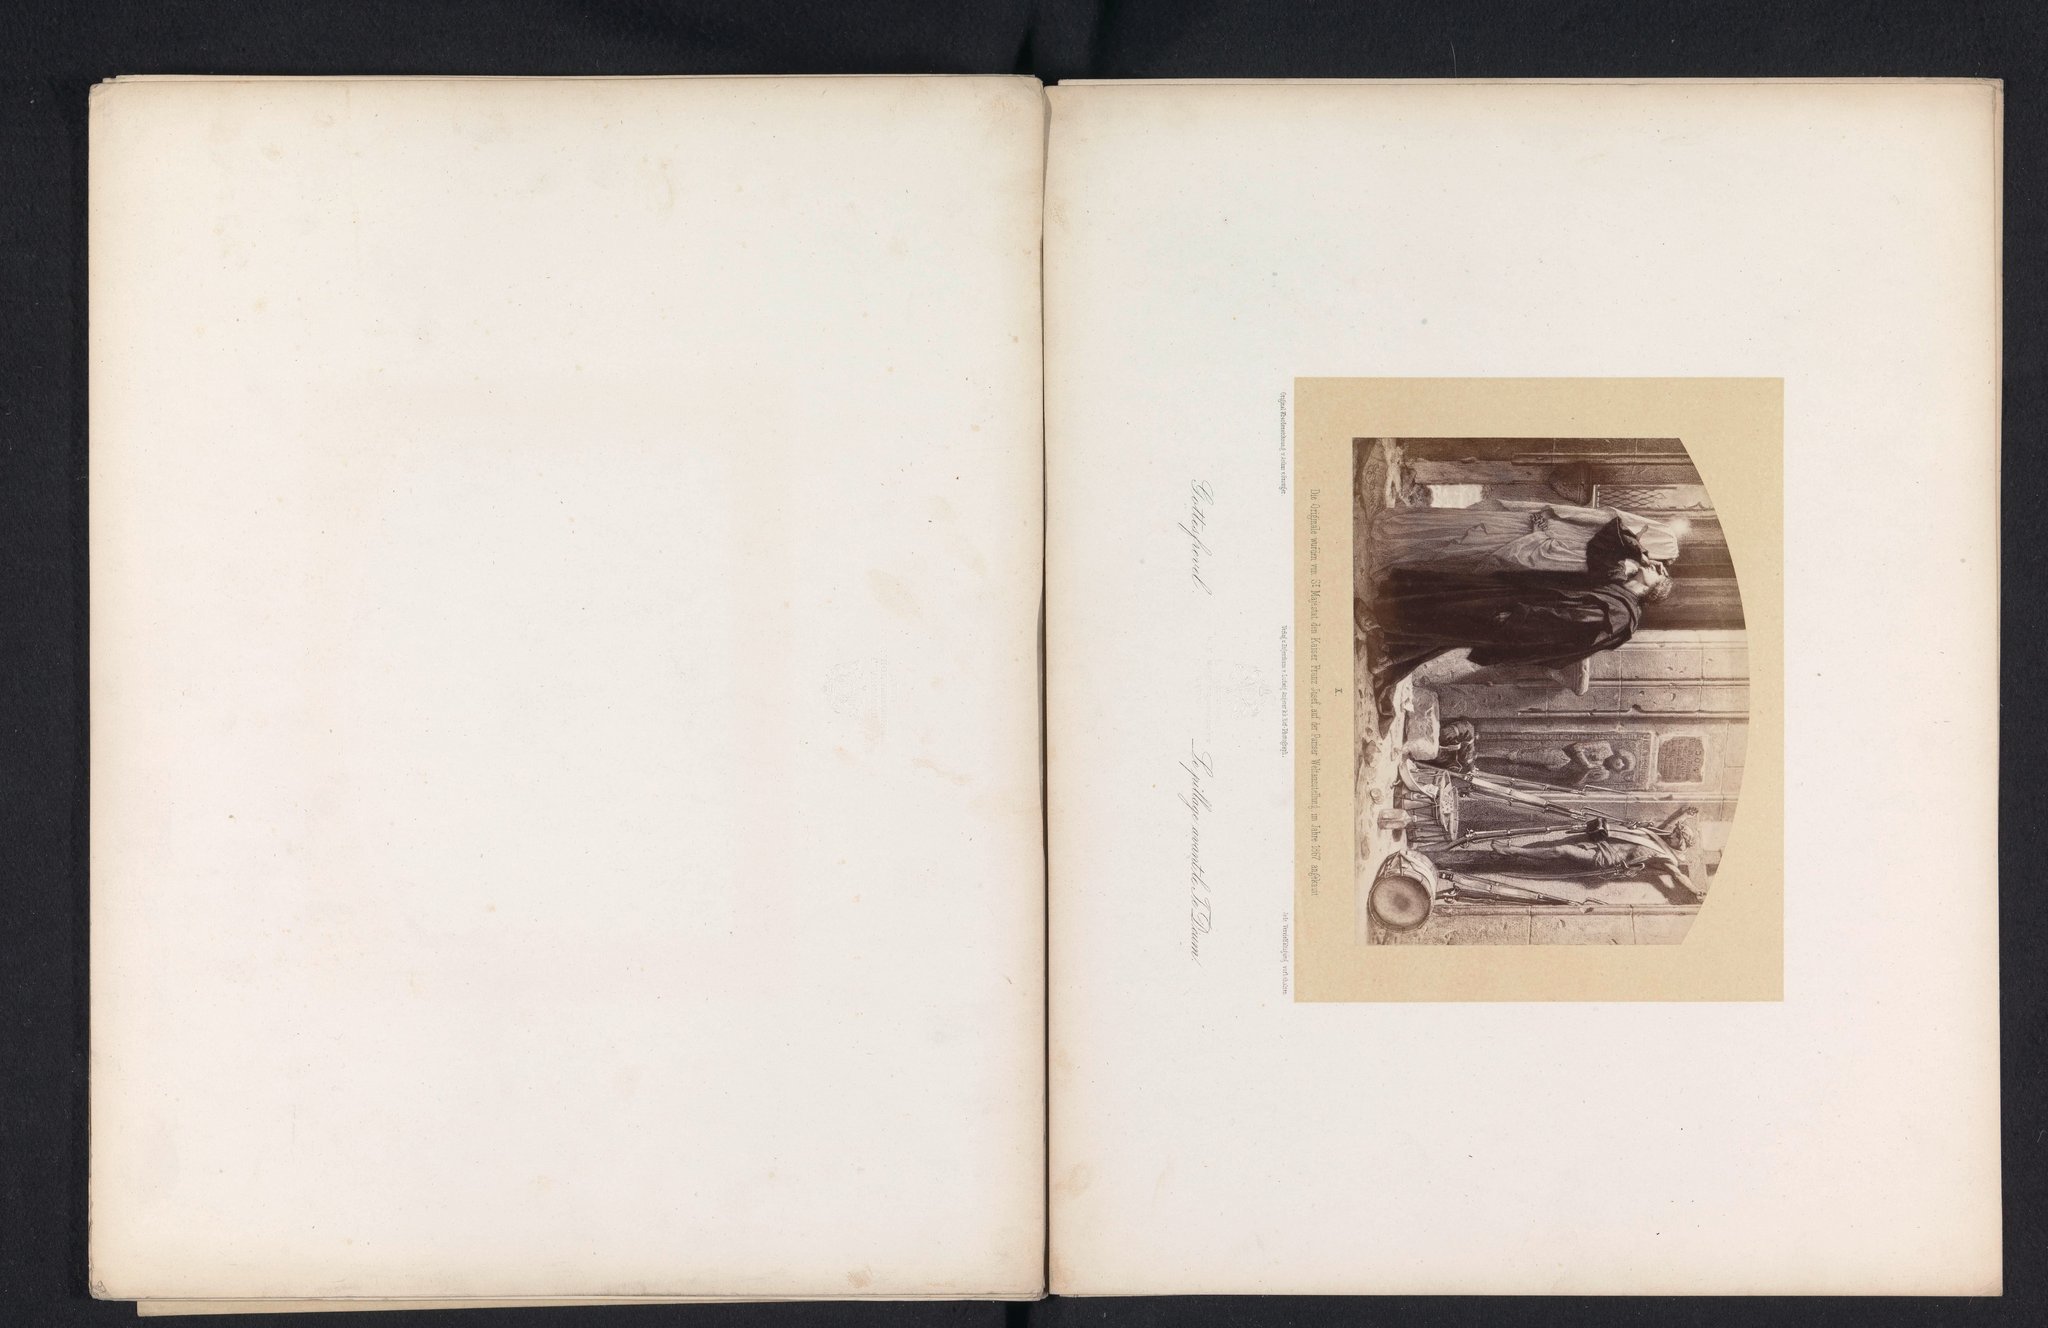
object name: reproduction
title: Fotoreproductie van een tekening van een interieur van een verwoeste kerk met wapens aan een Christusbeeld en een man naast vermoedelijk een engel die dit niet wil zien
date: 1867-1868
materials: photographic support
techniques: albumen print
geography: vienna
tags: sacrilege; 'sacrilegio' (ripa)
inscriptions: number: ‘X.’, inscription: ‘Die Originale wurden von Sr Majestat den Kaiser Franz Josef auf der Pariser Weltausstellung im Jahre 1867 angekauft.’